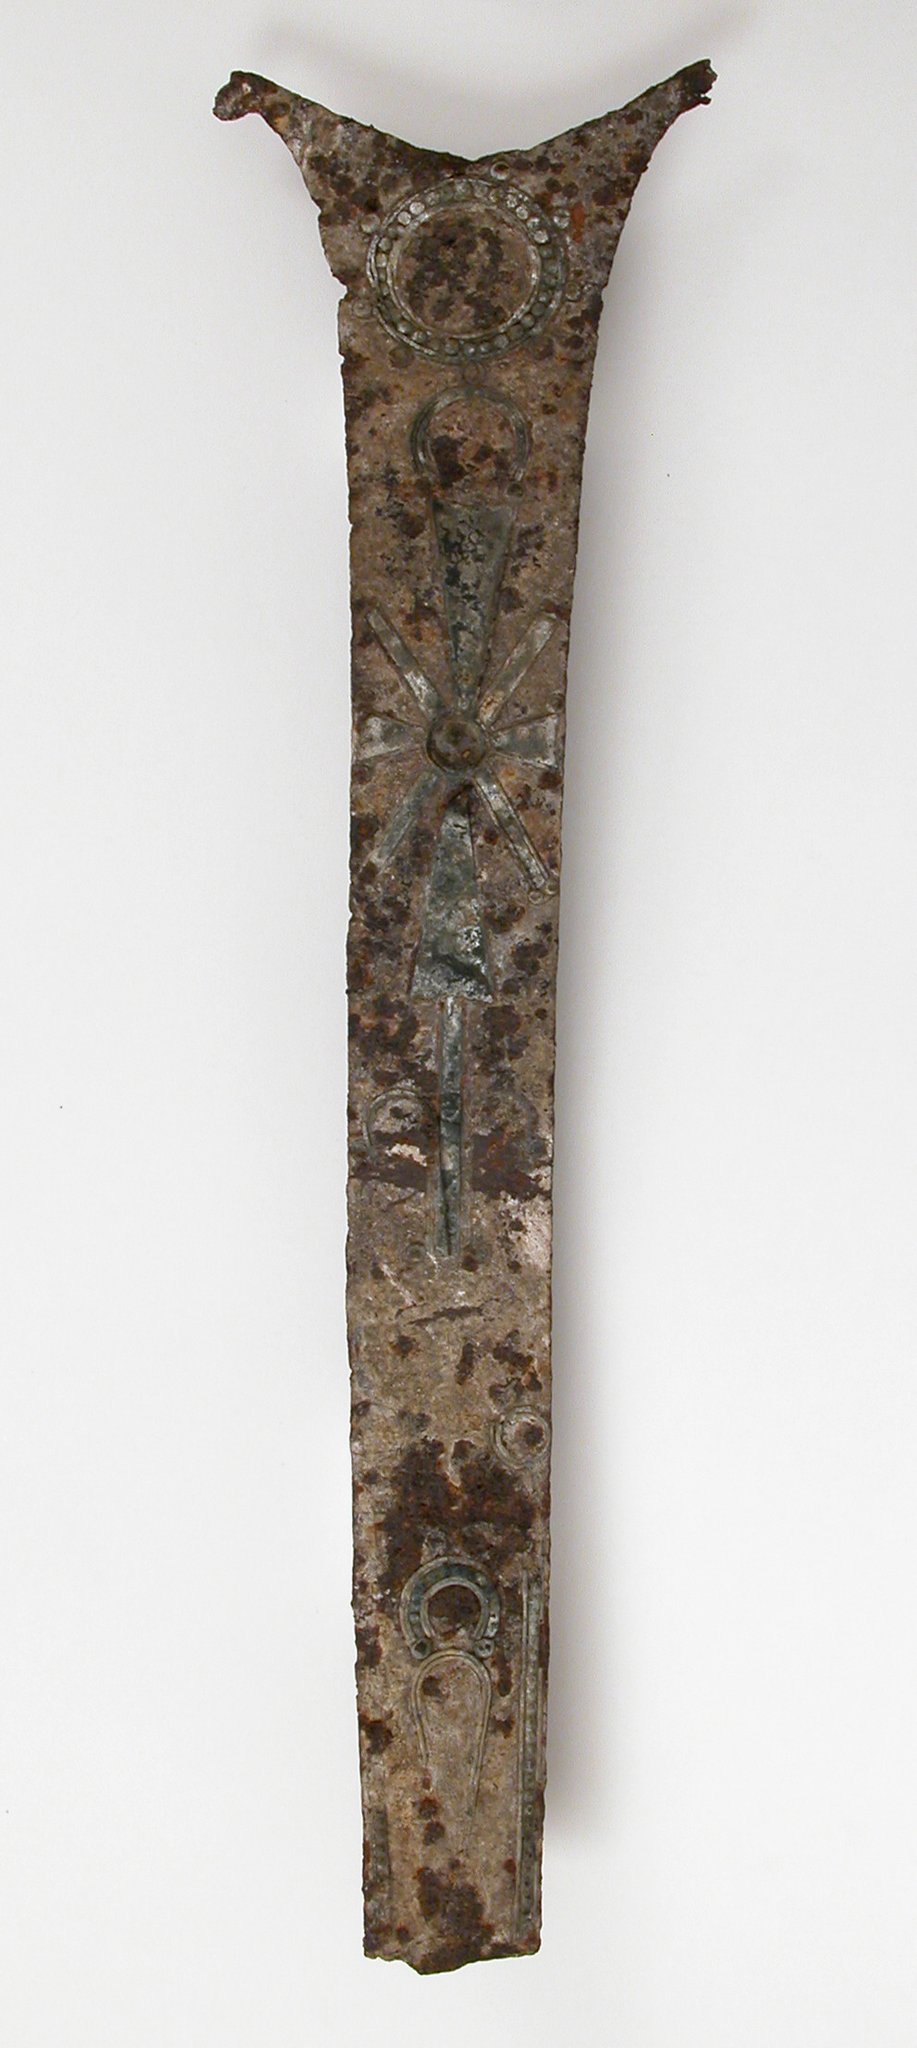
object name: cross arm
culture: byzantine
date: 901-1400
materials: iron, metal